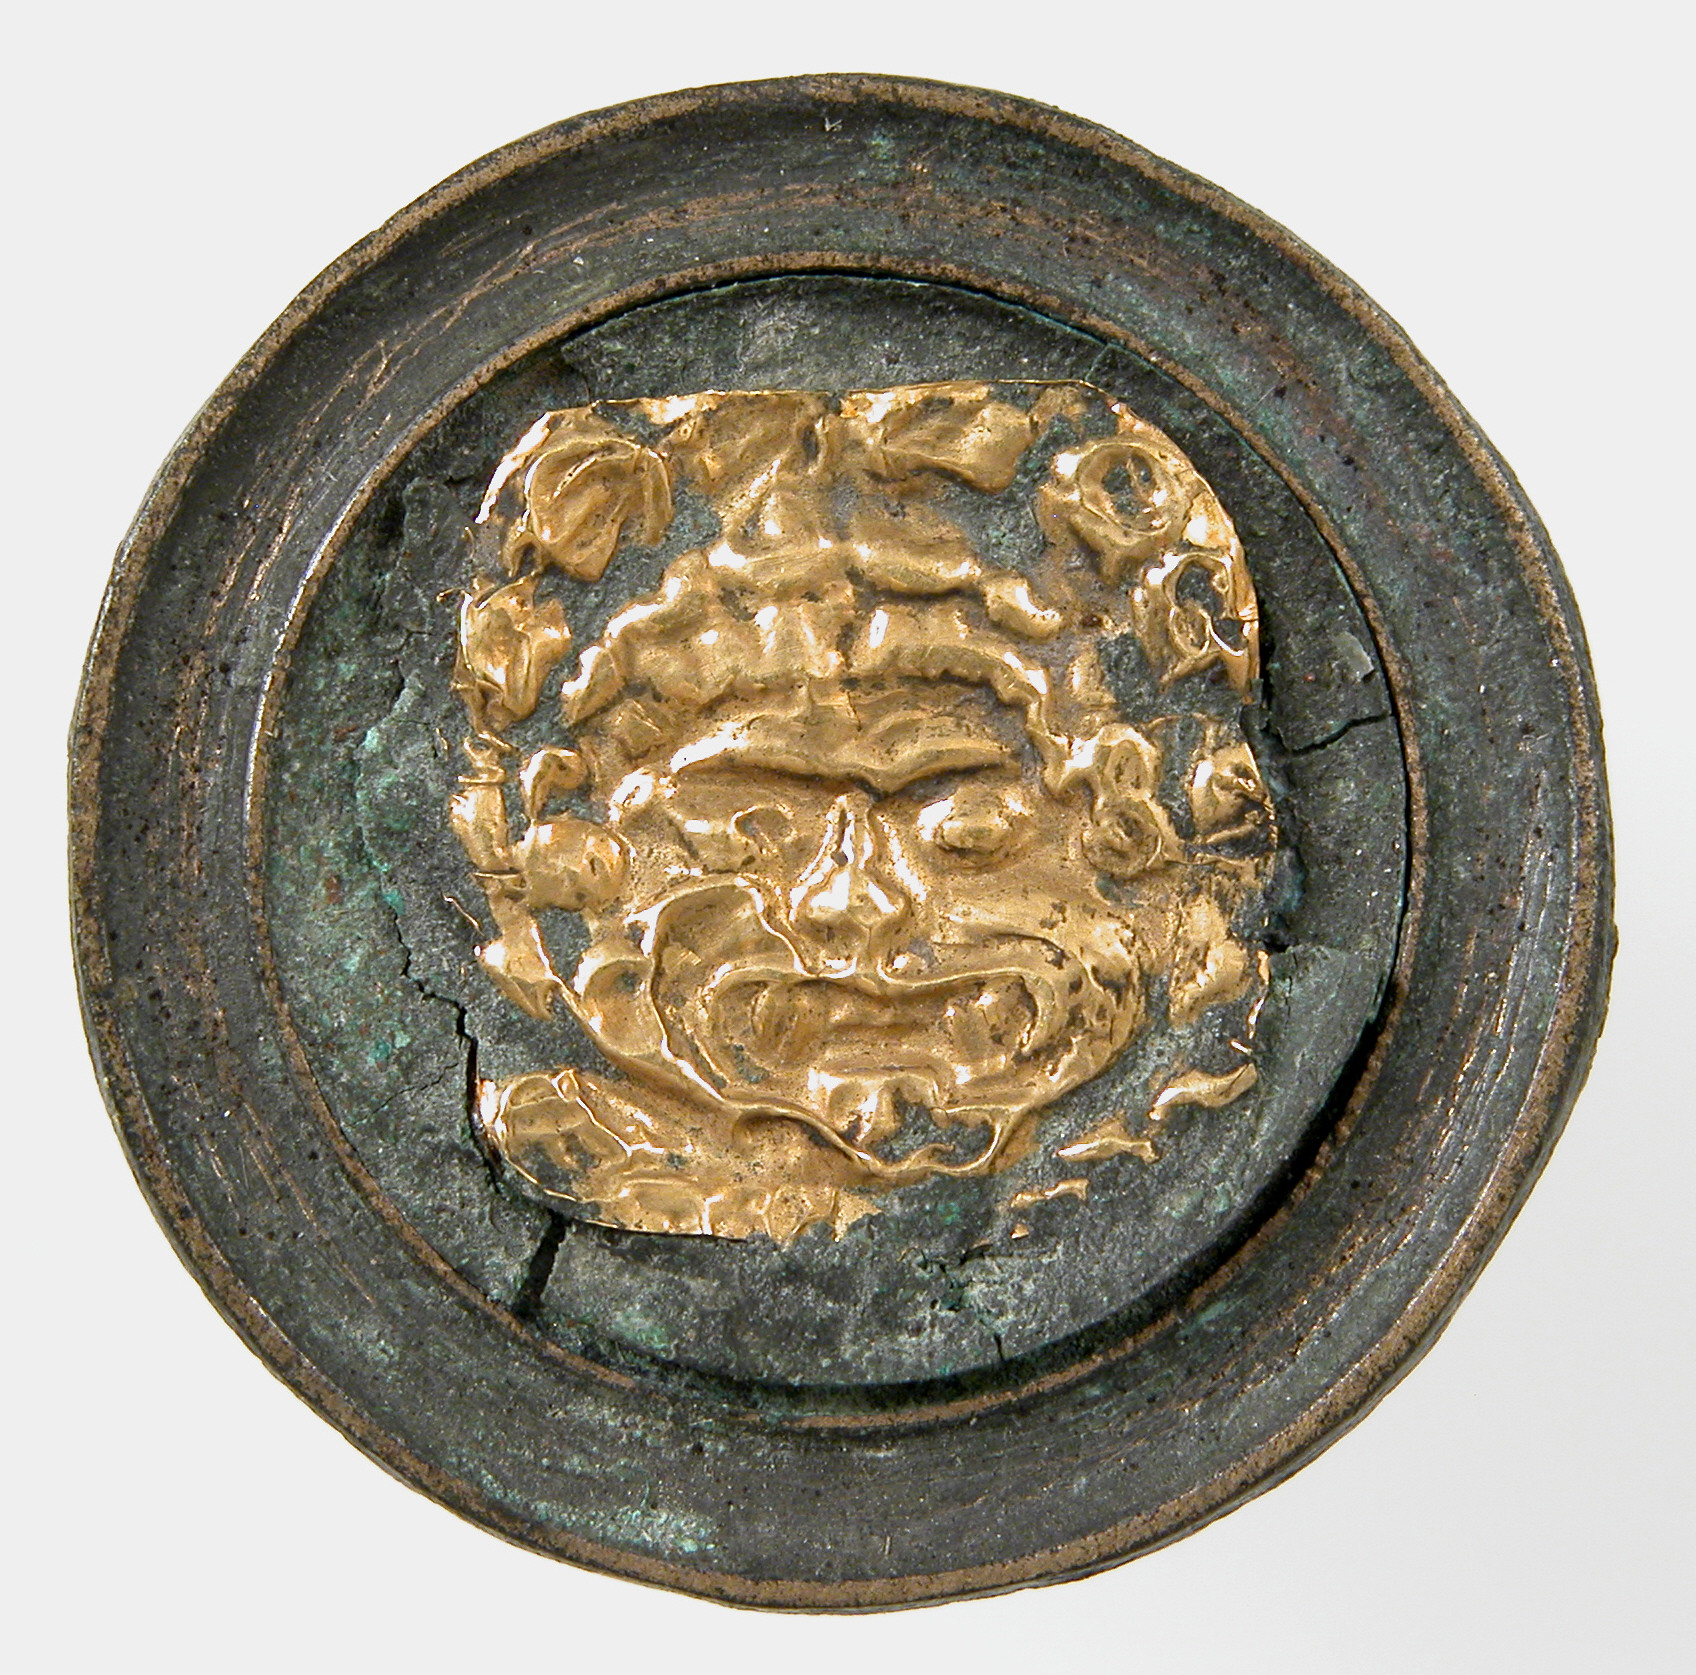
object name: bracteate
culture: roman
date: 200-500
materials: copper alloy, gold